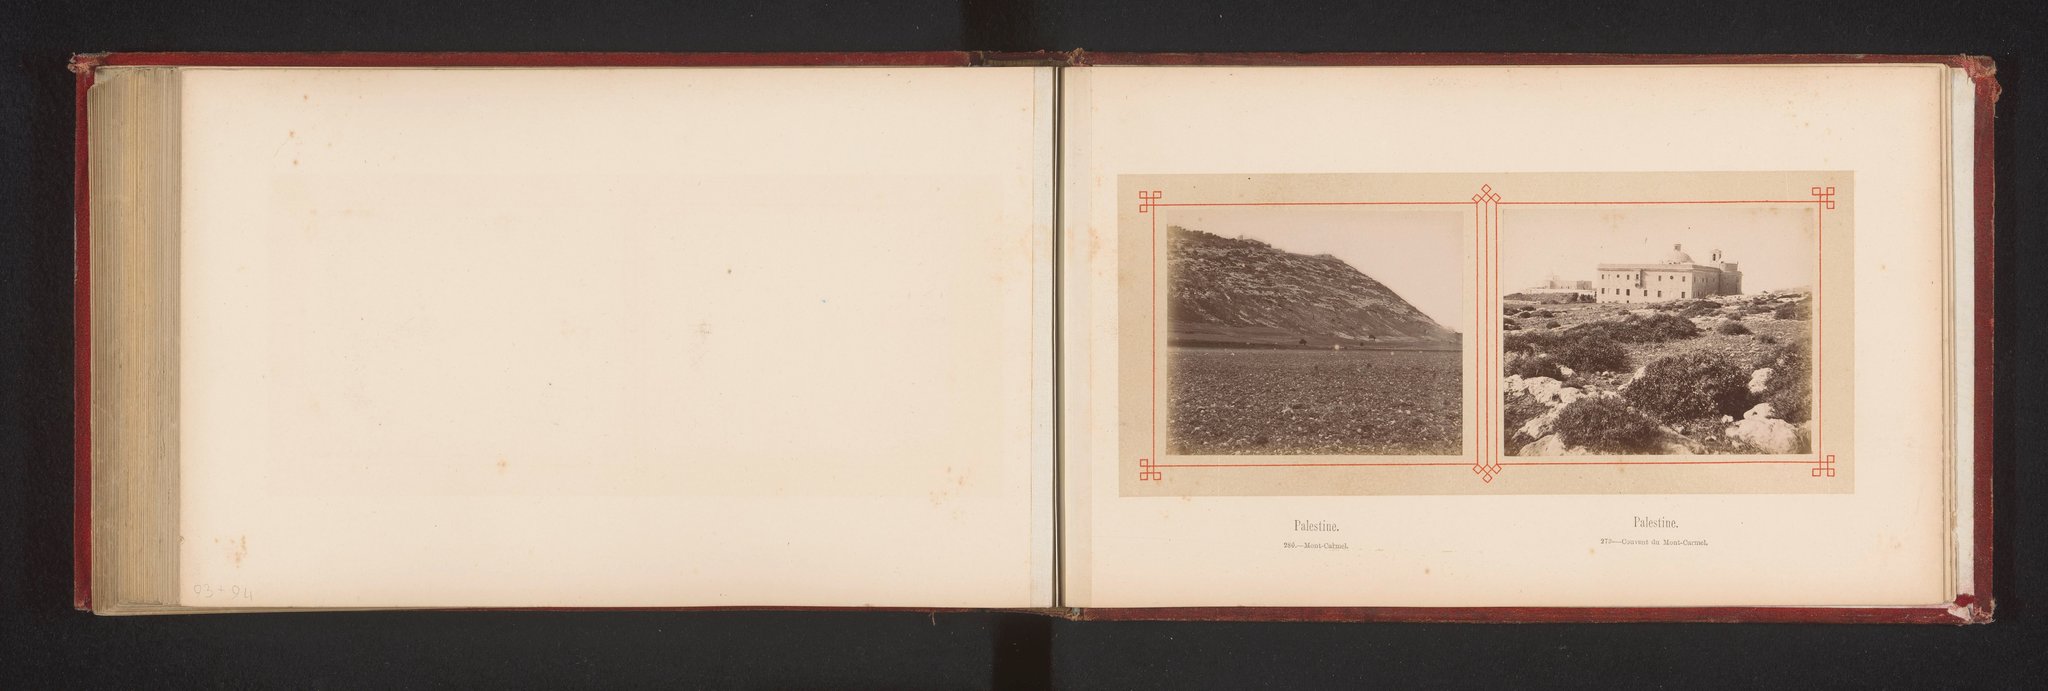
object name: photograph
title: Palestine - 280. Mont Carmel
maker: félix bonfils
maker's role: fotograaf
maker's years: 1831-1885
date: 1873-1878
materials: photographic support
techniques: albumen print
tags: mountains